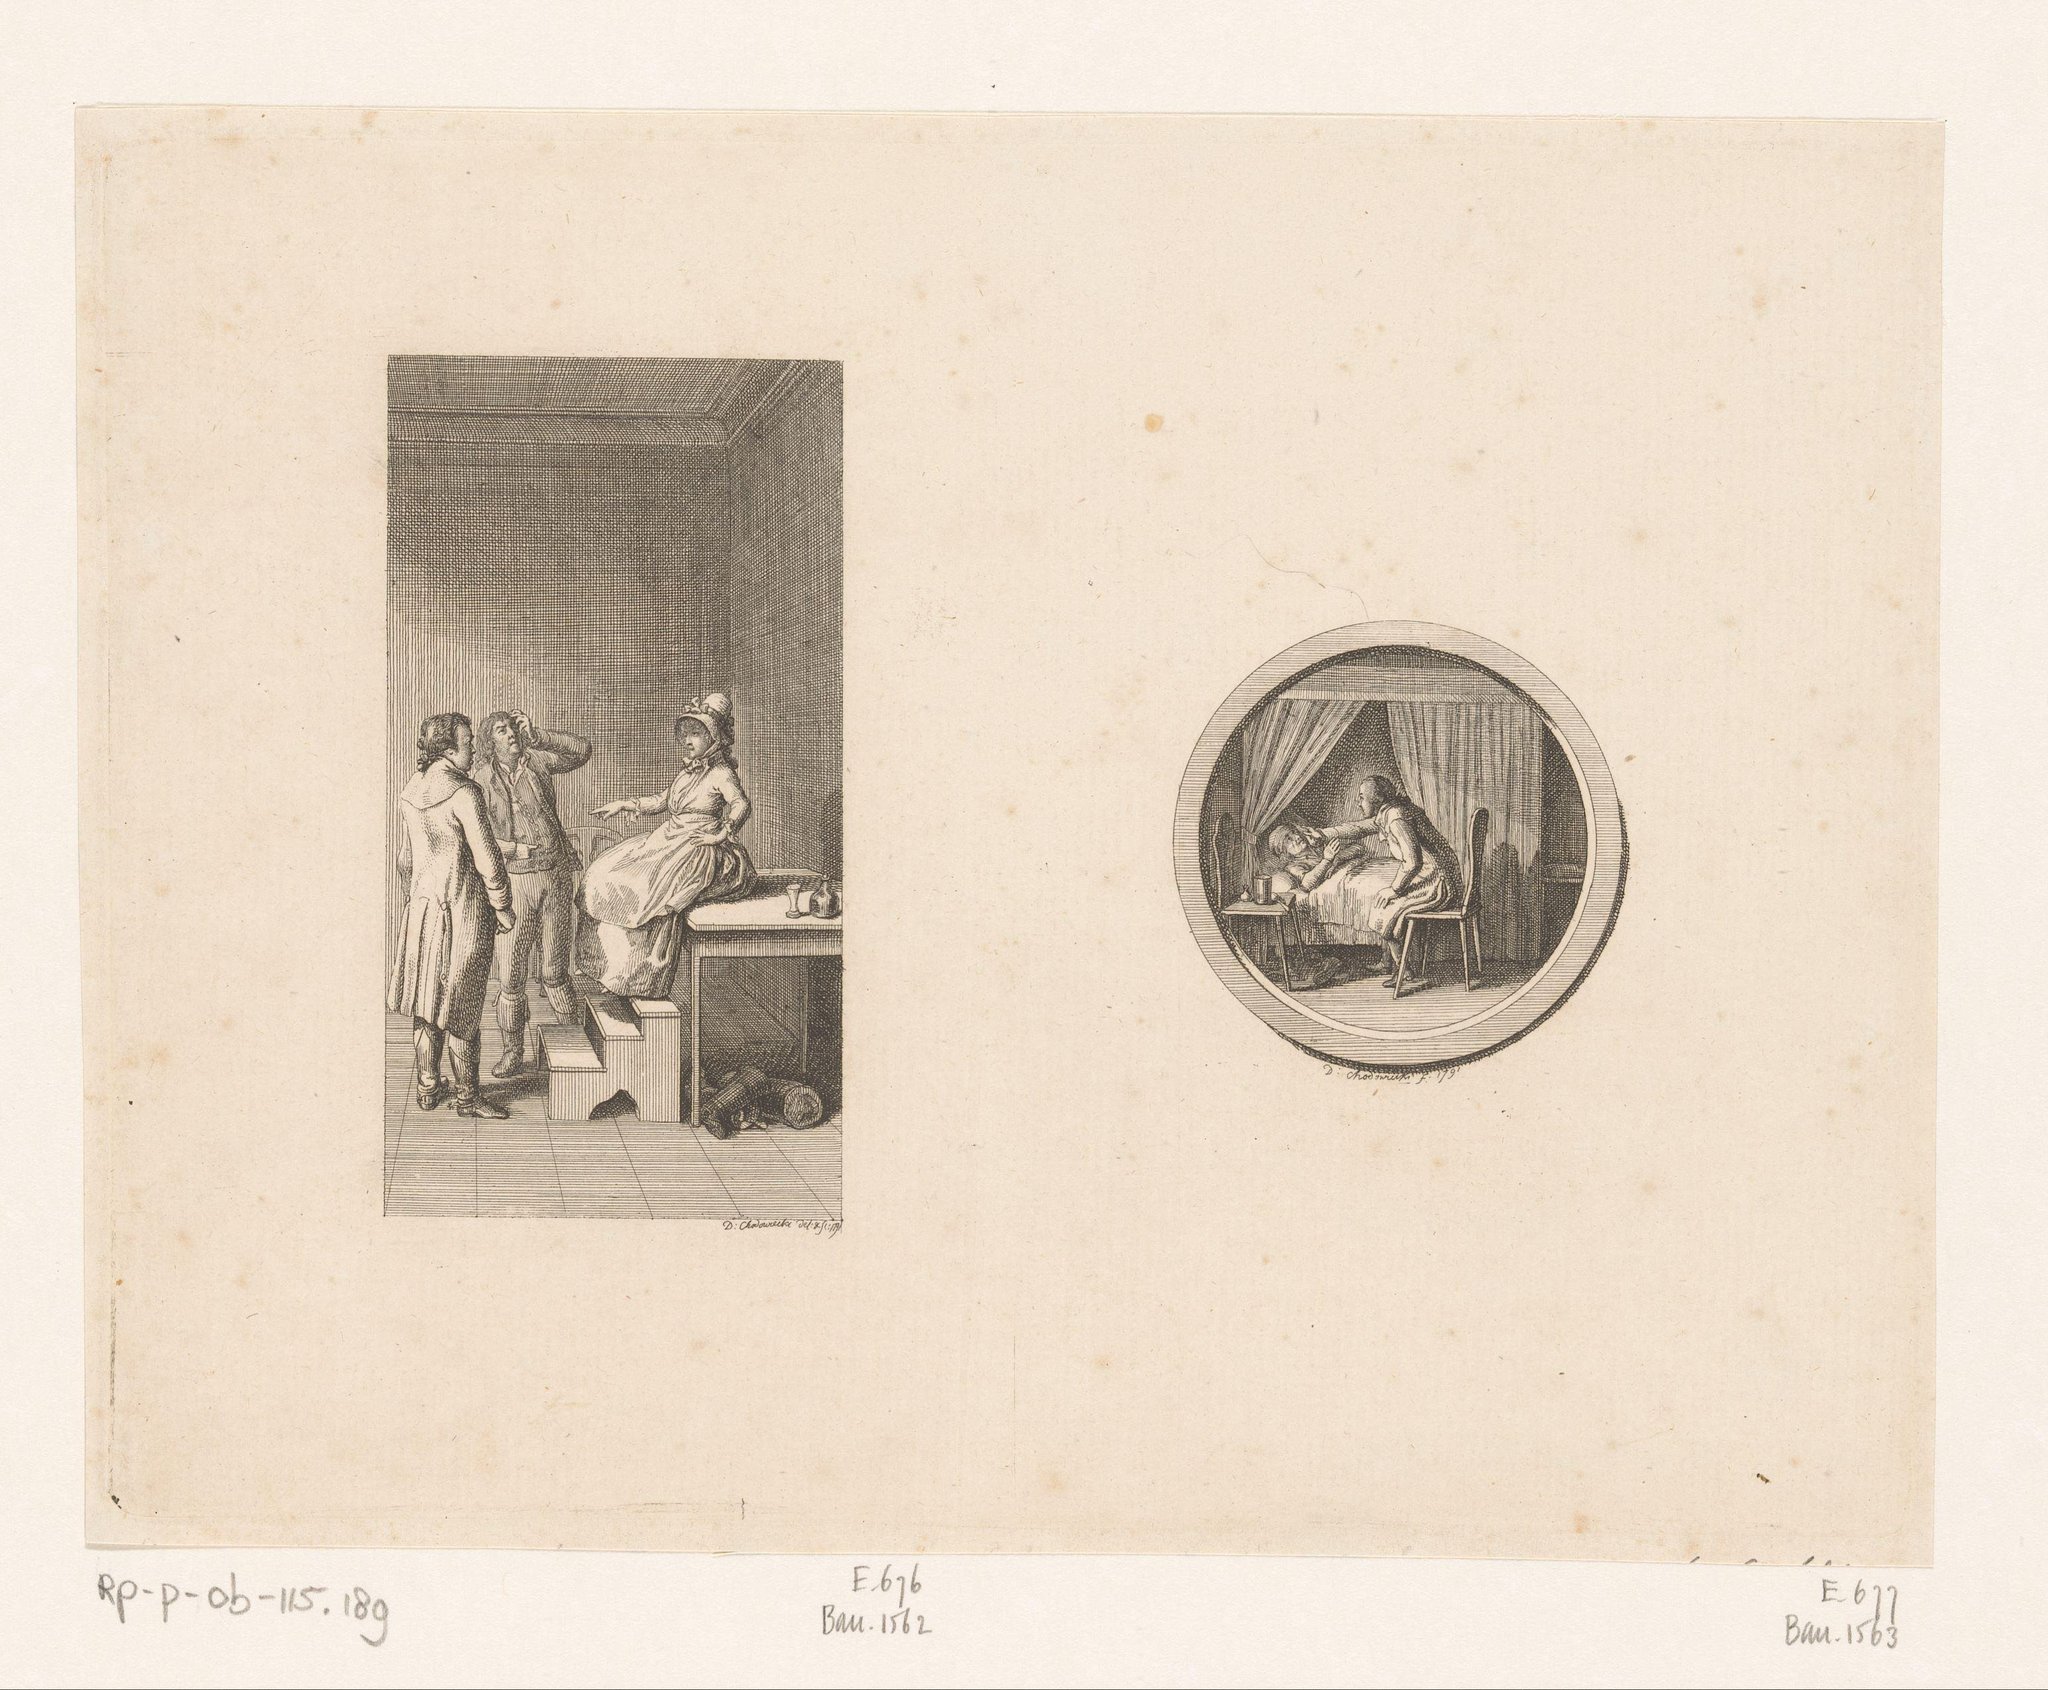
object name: print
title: Twee voorstellingen voor Jakob und sein Herr van Diderot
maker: daniel nikolaus chodowiecki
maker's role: draughtsman, print maker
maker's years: 1726-1801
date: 1791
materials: paper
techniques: etching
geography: berlin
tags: sitting figure - aa - female human figure, literature, sick-bed, staircase, index finger forwards, pointing, indicating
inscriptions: collector's mark: Lugt 2228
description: Prent gebruikt voor: Diderot, Denis. Jakob und sein Herr, aus Diderots ungedrucktem Nachlasse (...). Berlijn: Johann Friedrich Unger, 1792.